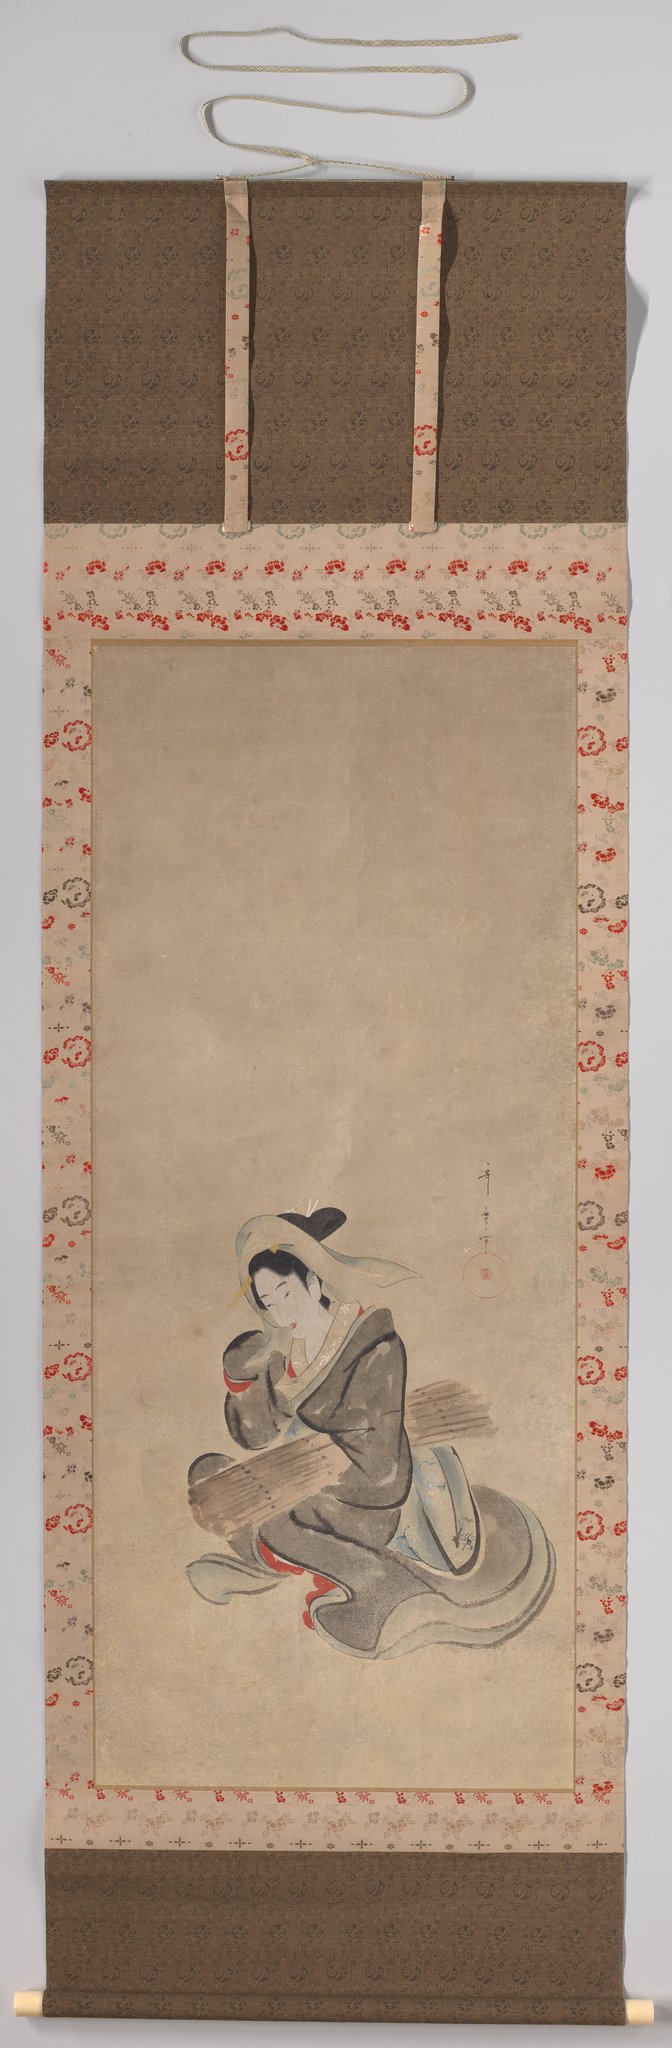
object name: hanging scroll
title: Rolschildering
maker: Anonymous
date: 1800-1900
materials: paper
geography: japan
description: Een yotaka, een laag soort prostitue met een opgerold matje onder de linkerarm. In houten doos.